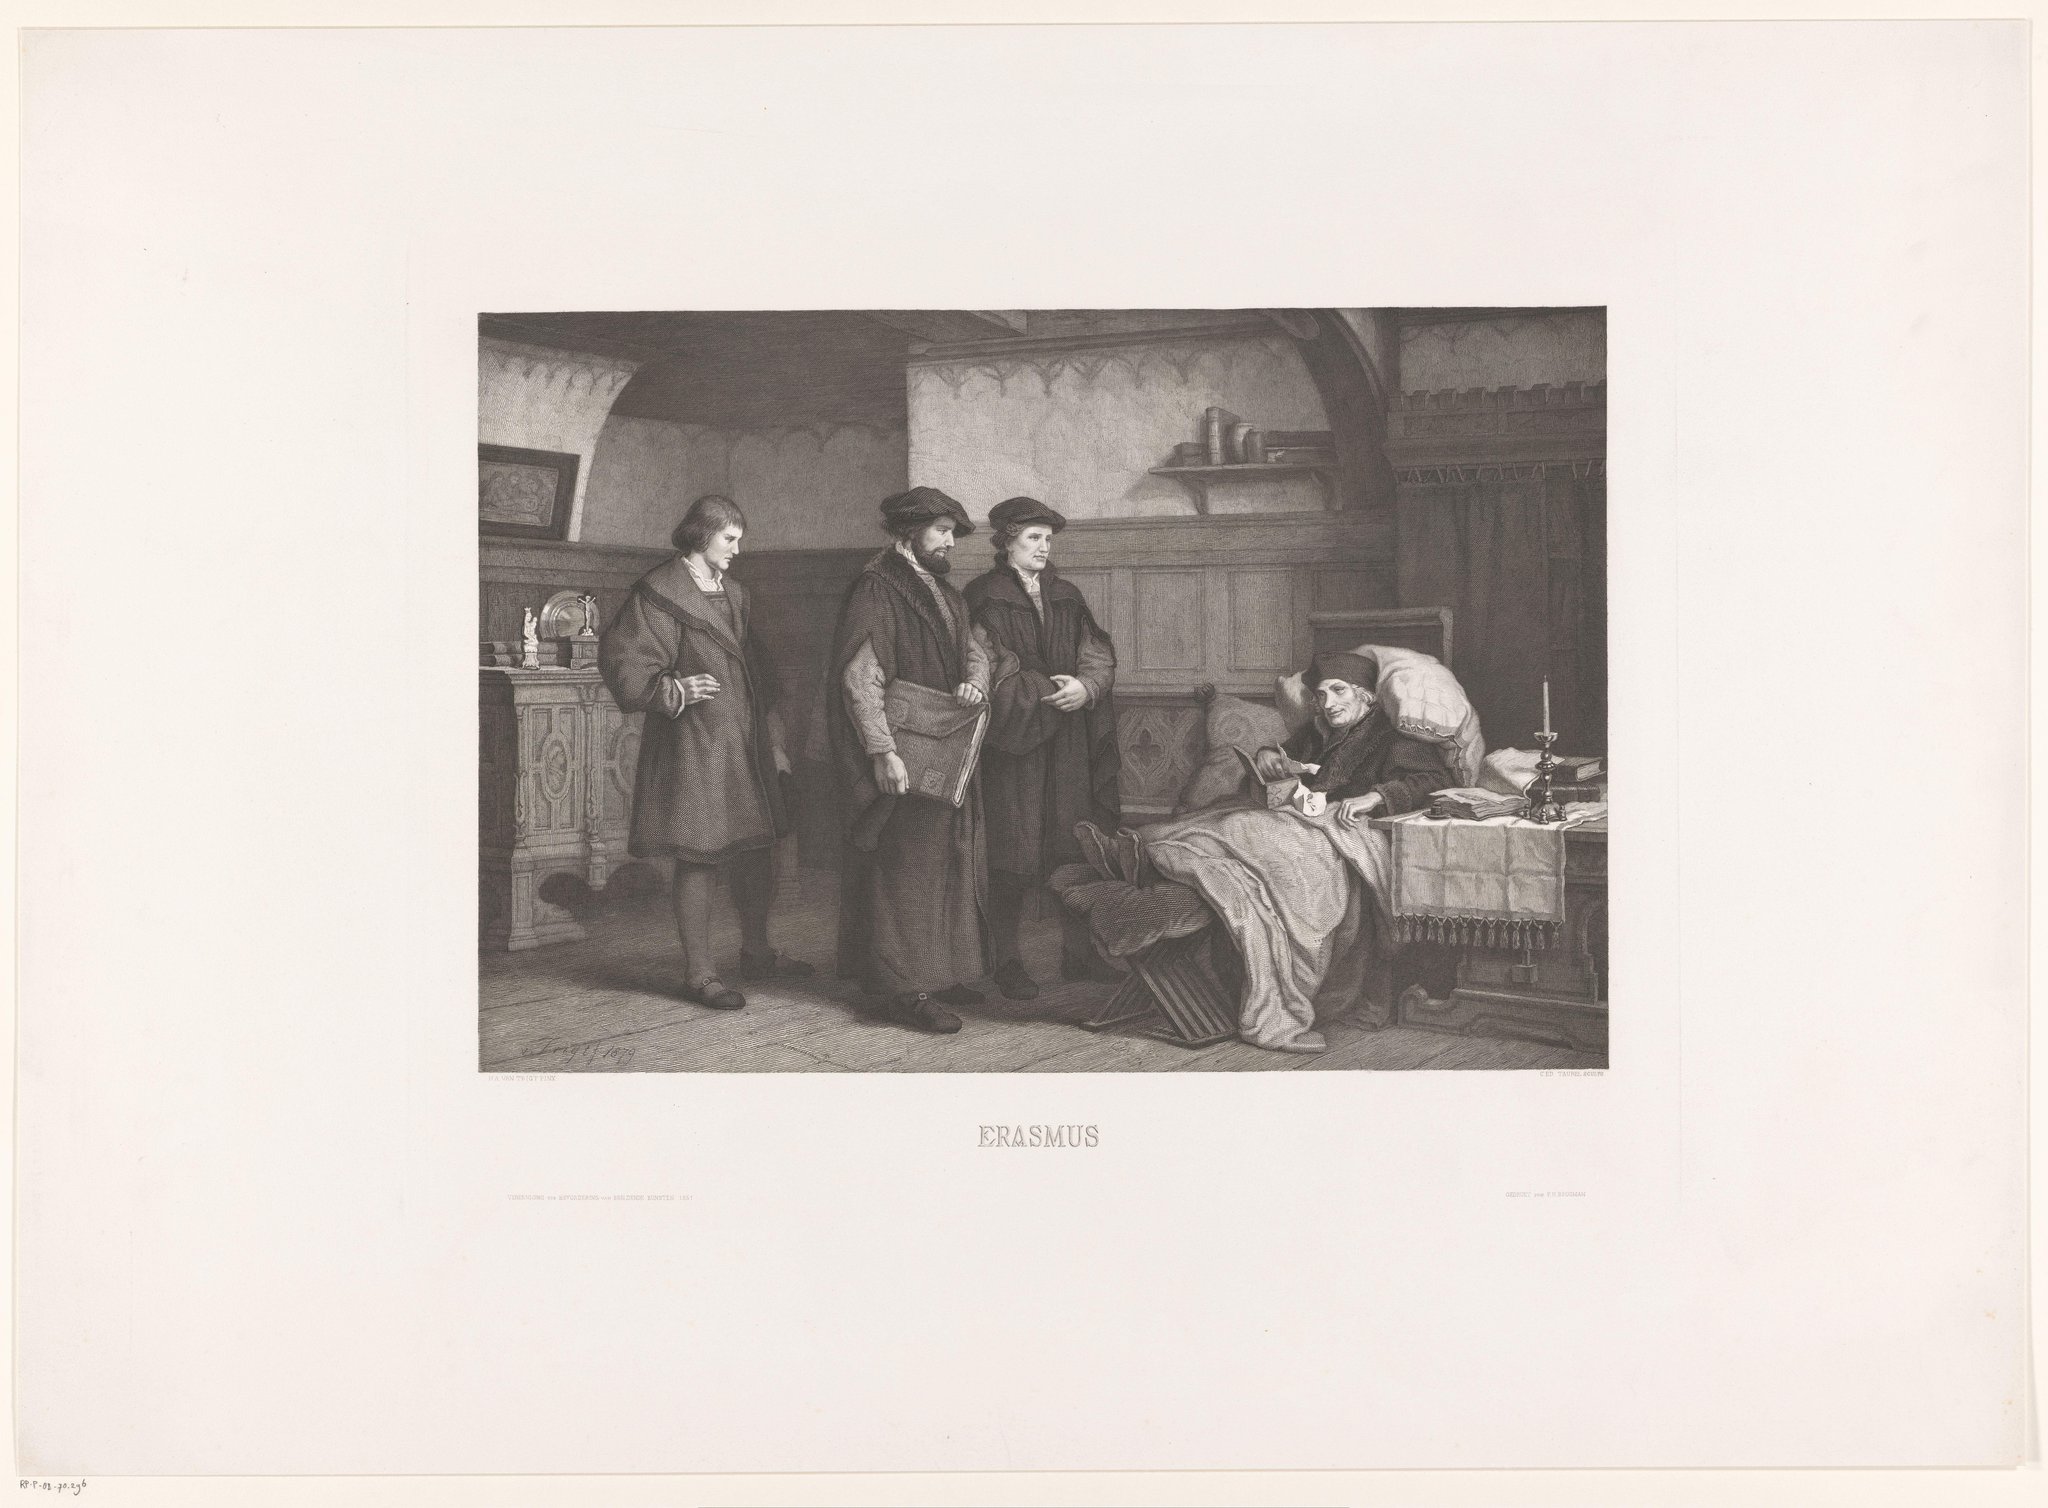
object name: print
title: Erasmus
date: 1881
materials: paper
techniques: engraving, etching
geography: amsterdam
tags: desiderius erasmus, printer, publisher, johann froben, sick-bed, interior of the house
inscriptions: collector's mark: Lugt 2228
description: De humanistische geleerde Desiderius Erasmus op zijn ziekbed in Bazel, met drie heren in een interieur, waaronder vermoedelijk de Bazelse drukker Johann Froben, met een map onder zijn arm.